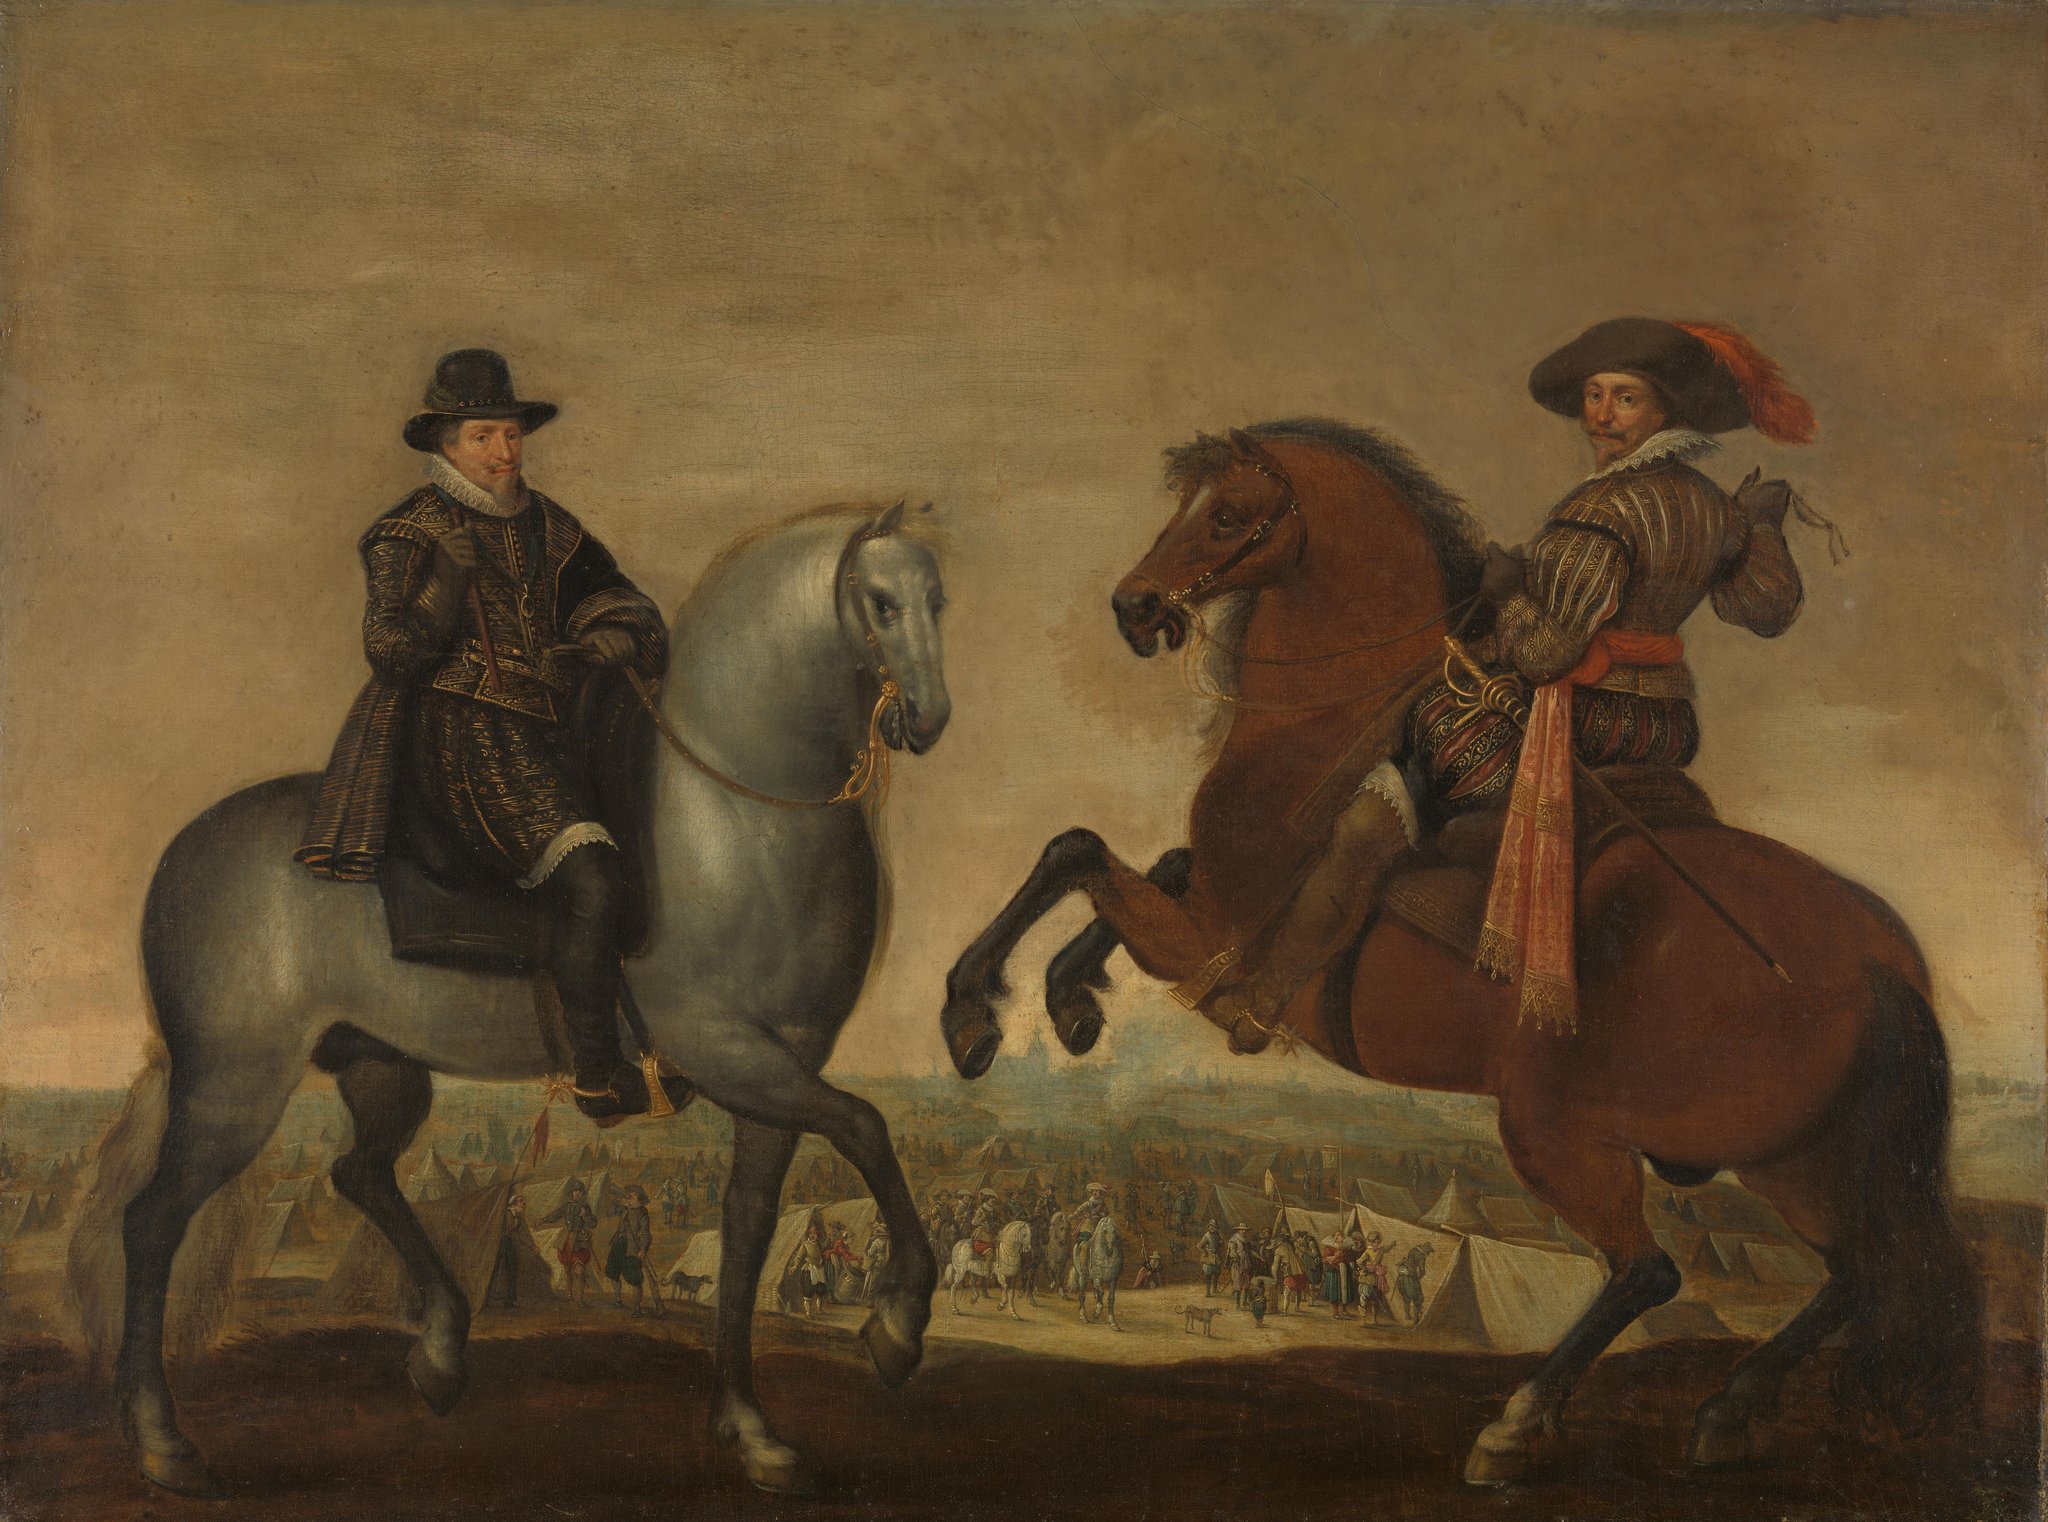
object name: painting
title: Princes Maurits and Frederik Hendrik on Horseback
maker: pauwels van hillegaert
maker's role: painter, print maker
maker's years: 1596-1658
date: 1630-1635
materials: canvas, oil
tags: maurice (prince of orange), equestrian state-portrait, riding a horse, ass, or mule; rider, horseman, (military) camp with tents, historical persons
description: Prins Maurits rijdt links op een wit paard. Prins Frederik Hendrik zit op een steigerend bruin paard. Op de achtergrond bezoeken officieren te paard een legerkamp.